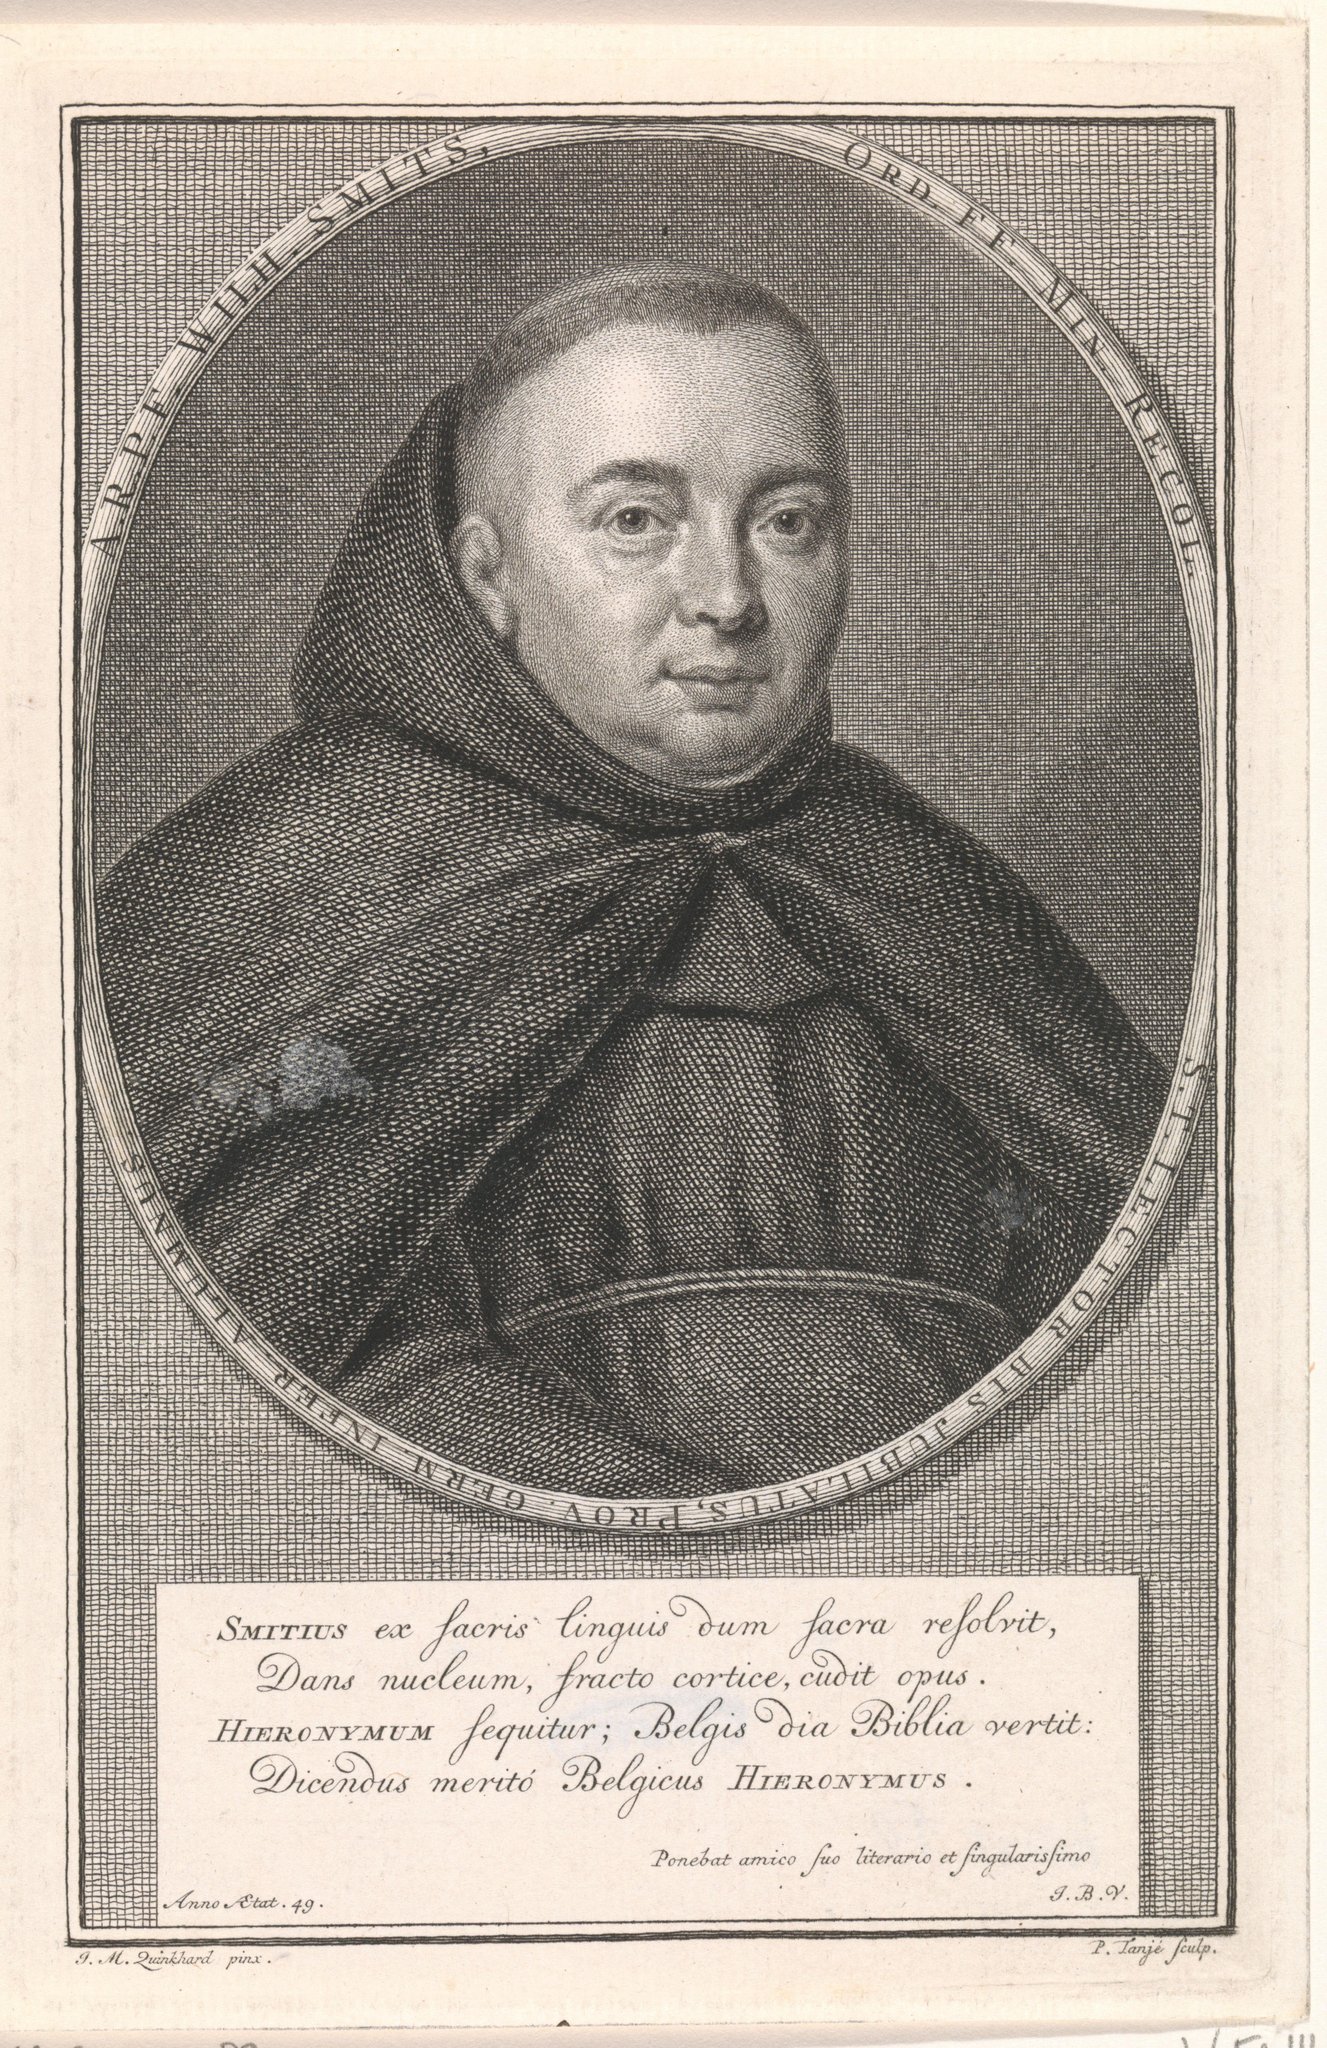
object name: print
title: Portret van Willem Smits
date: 1716-1761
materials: paper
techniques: engraving, etching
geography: amsterdam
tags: monk(s), friar(s)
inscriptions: collector's mark: Lugt 2228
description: Portret van Willem Smits, monnik van de orde van de Recolletten en bijbeluitlegger. Onderaan in de marge een vierregelig vers in het Latijn.